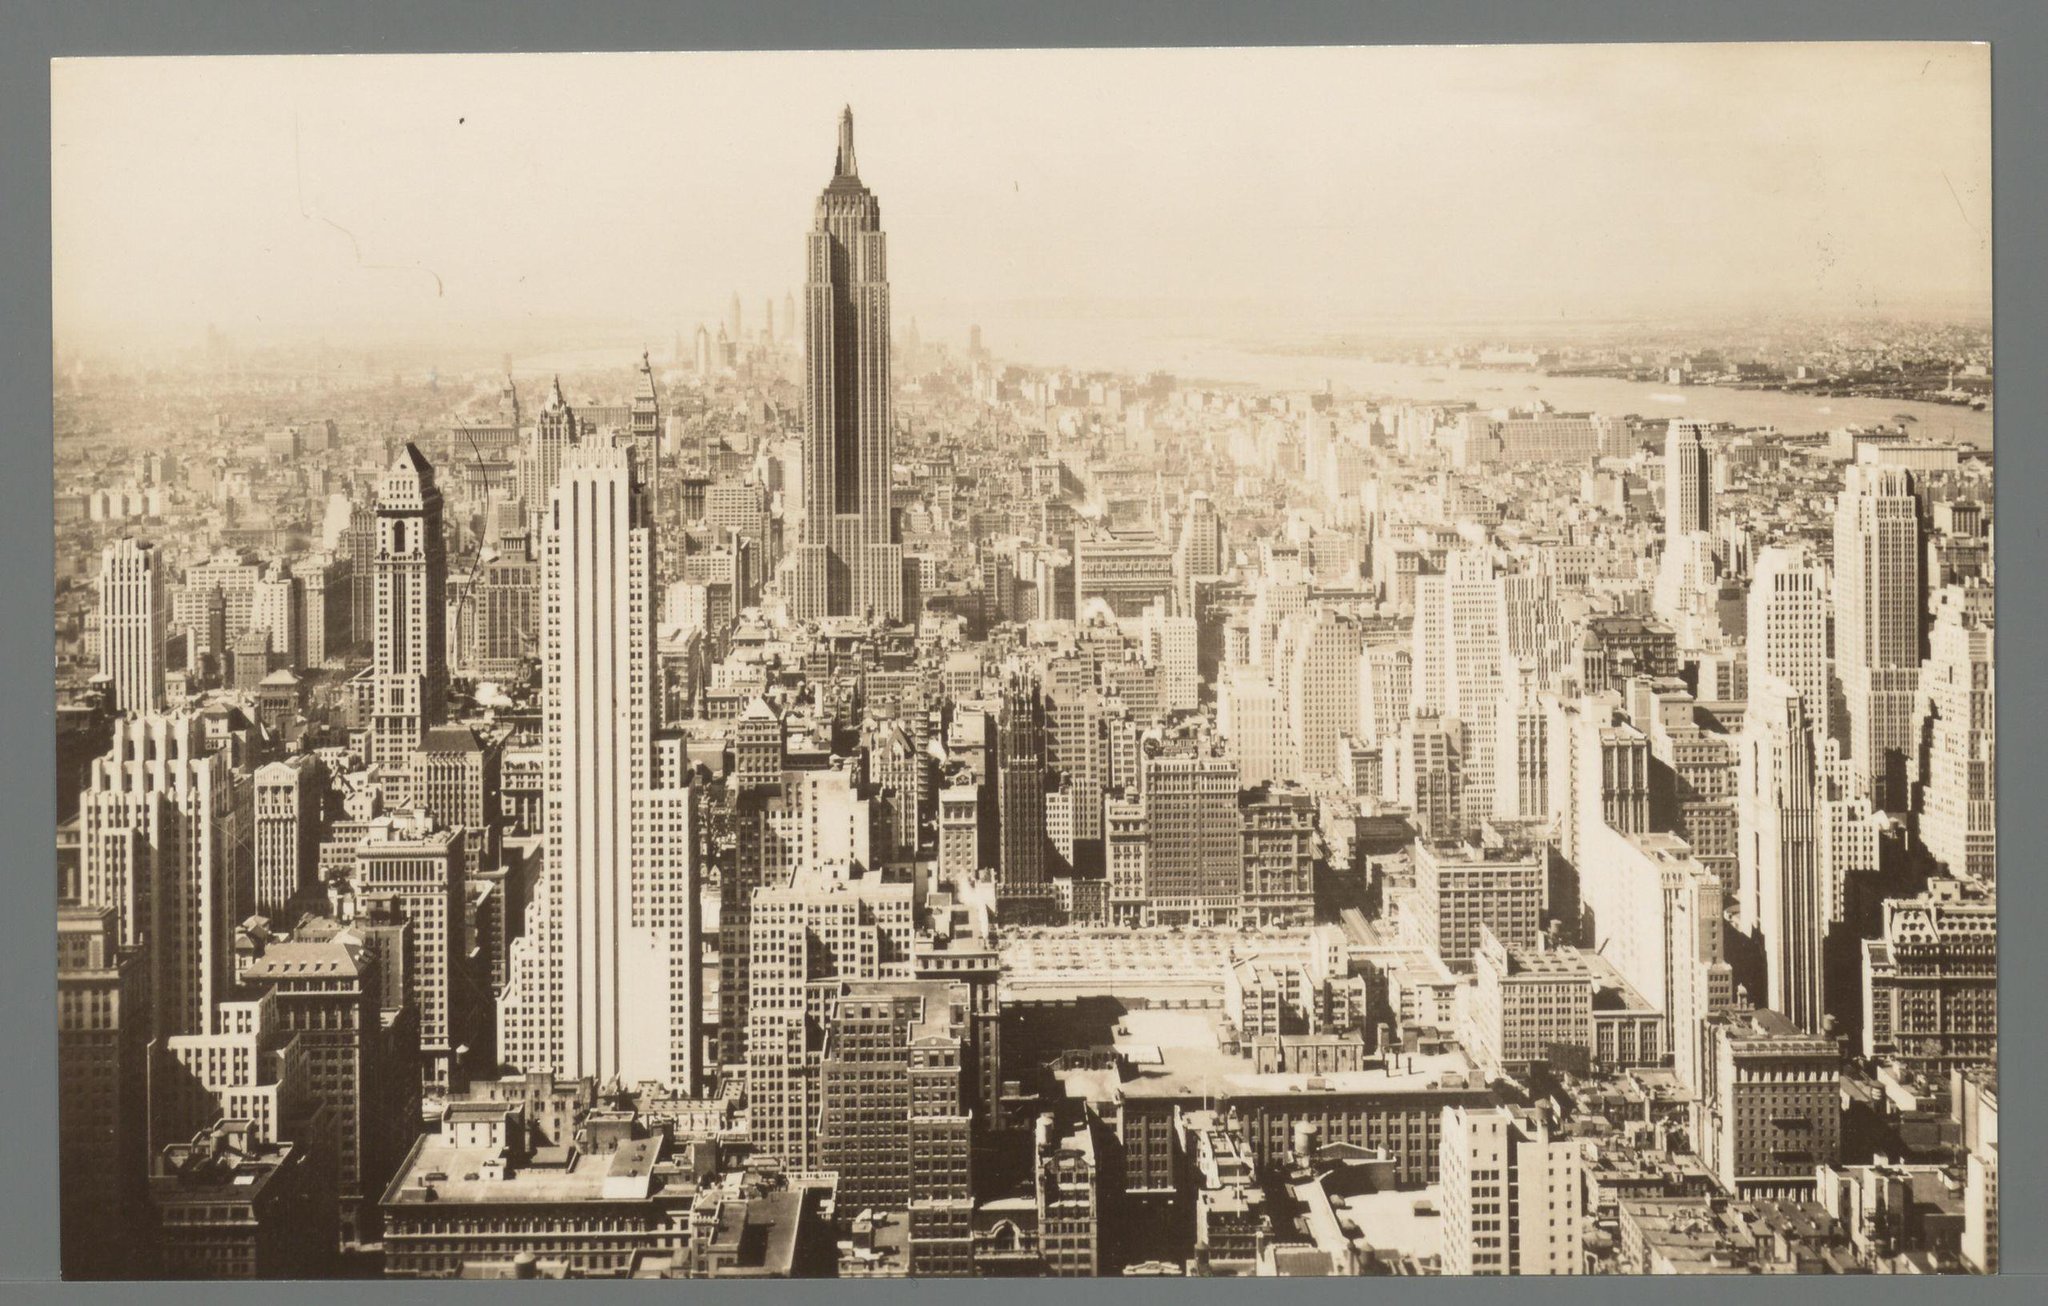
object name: photograph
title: Rockefeller Center. Looking south from the 70th floor of the RCA Building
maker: e. ratcliffe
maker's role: fotograaf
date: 1930-1950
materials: photographic support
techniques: photography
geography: new york city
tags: prospect of city, town panorama, silhouette of city, manhattan